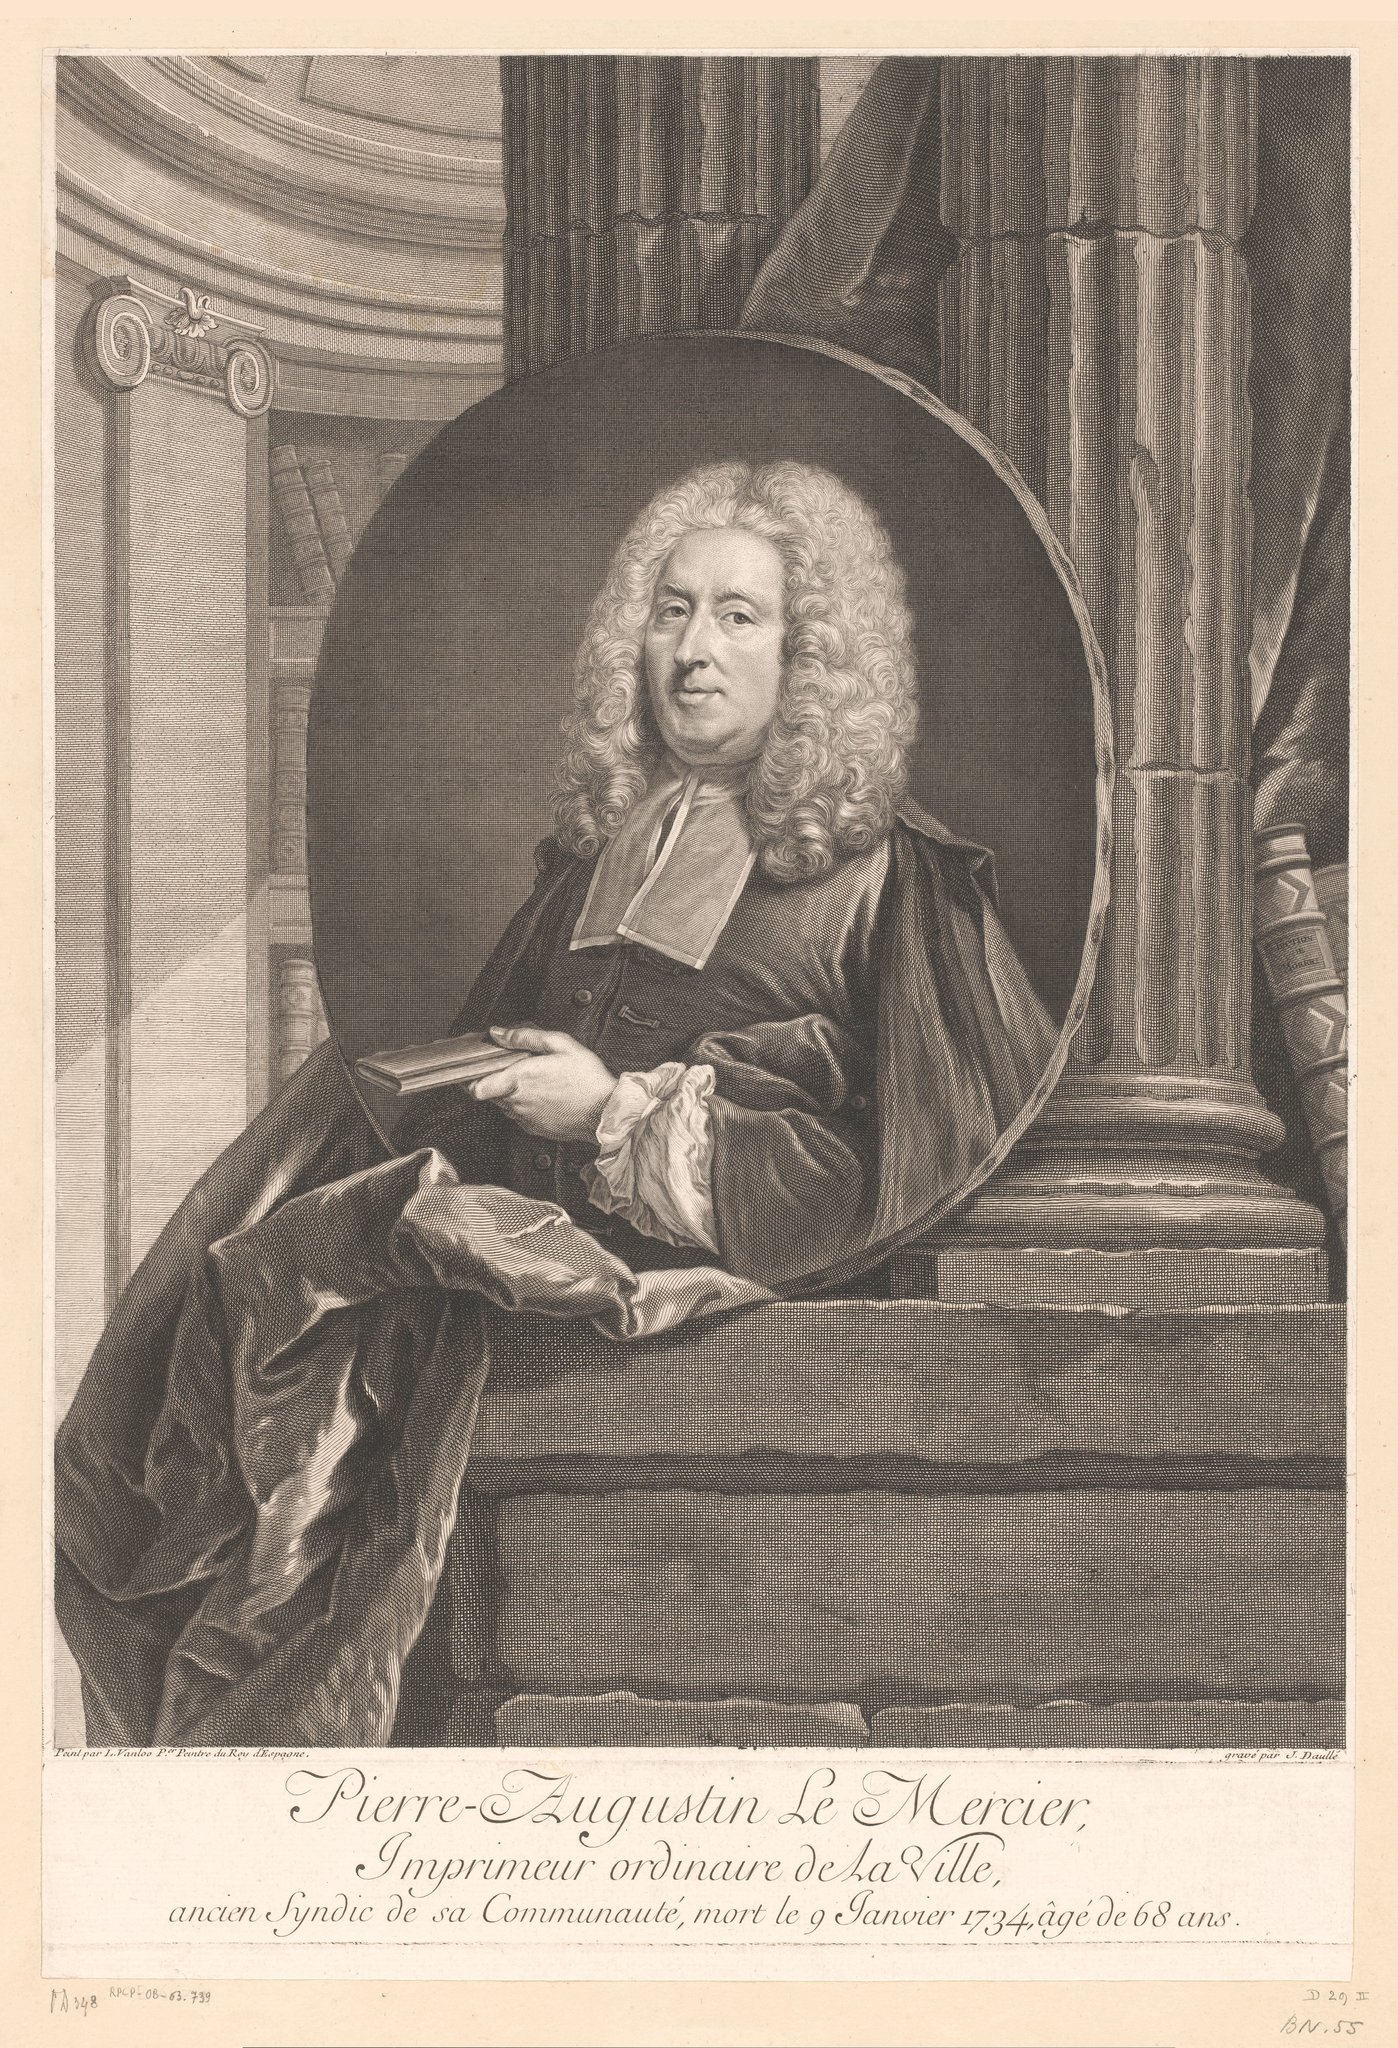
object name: print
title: Pierre-Augustin Le Mercier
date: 1734-1763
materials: paper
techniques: engraving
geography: france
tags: historical persons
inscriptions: collector's mark: Lugt 240